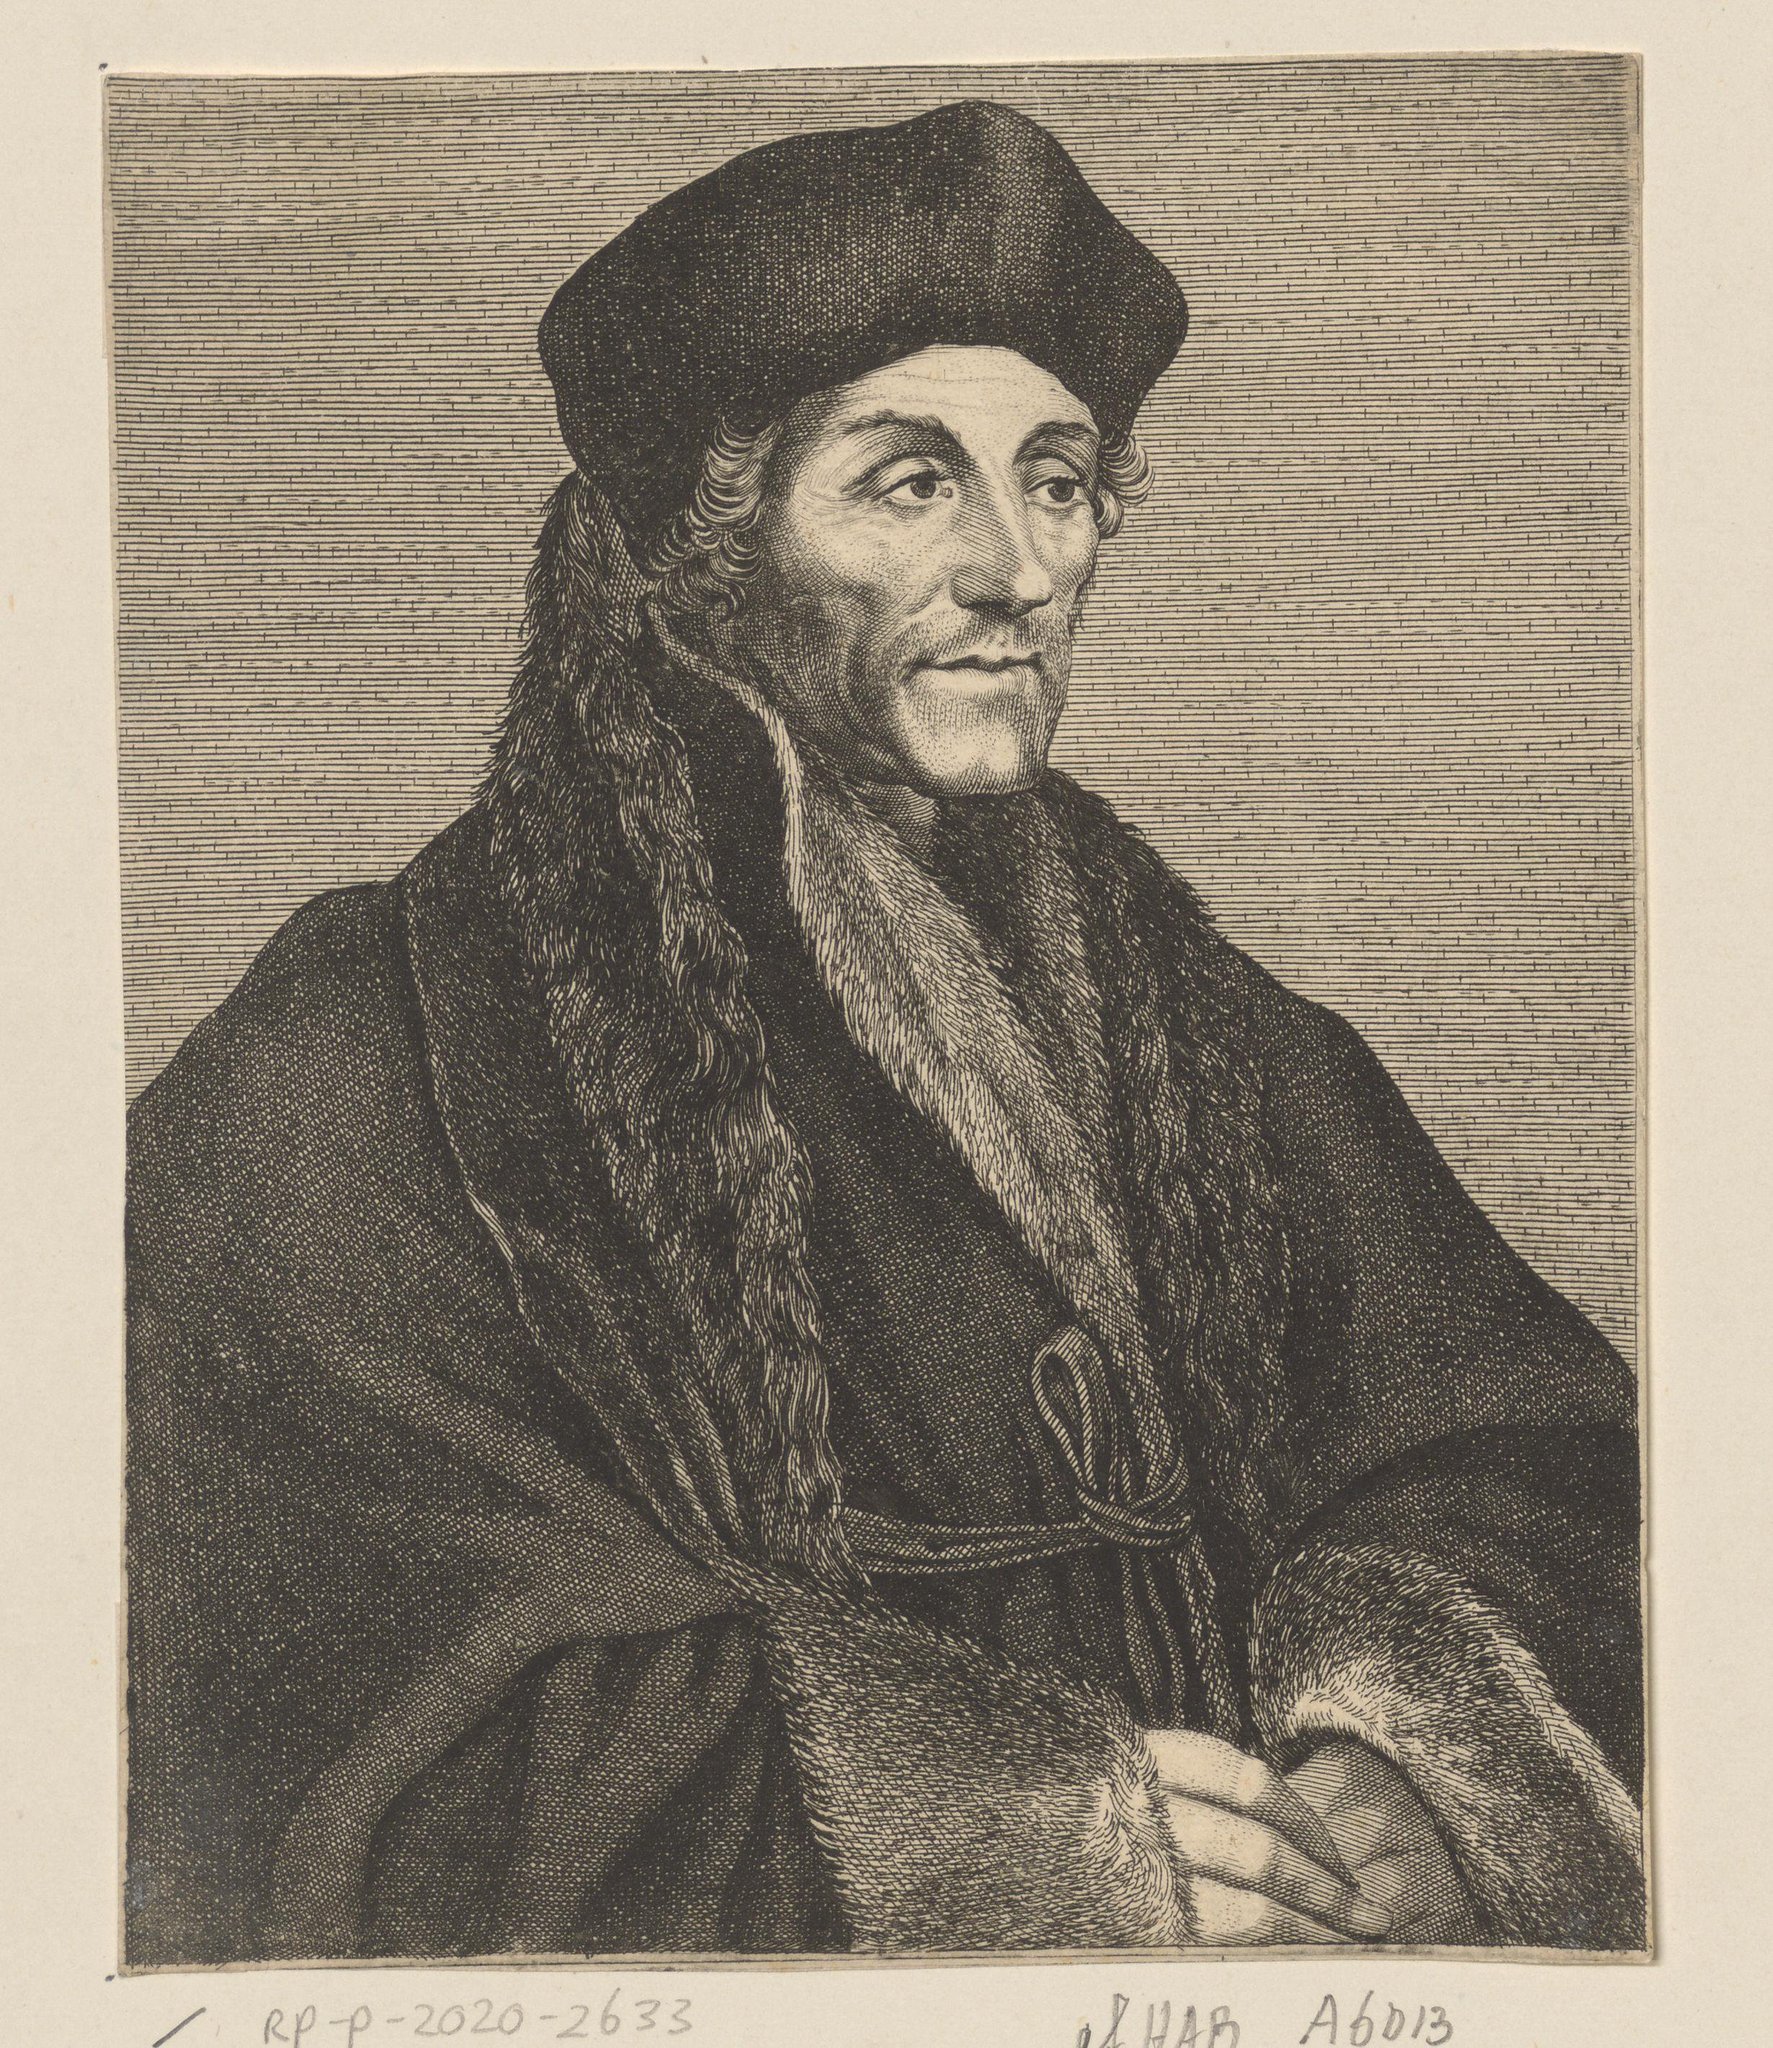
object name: print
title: Portret van Desiderius Erasmus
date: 1630-1680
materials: paper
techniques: engraving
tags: rotterdam, desiderius erasmus, historical persons, scholar, philosopher (+ portrait of scholar, scientist)